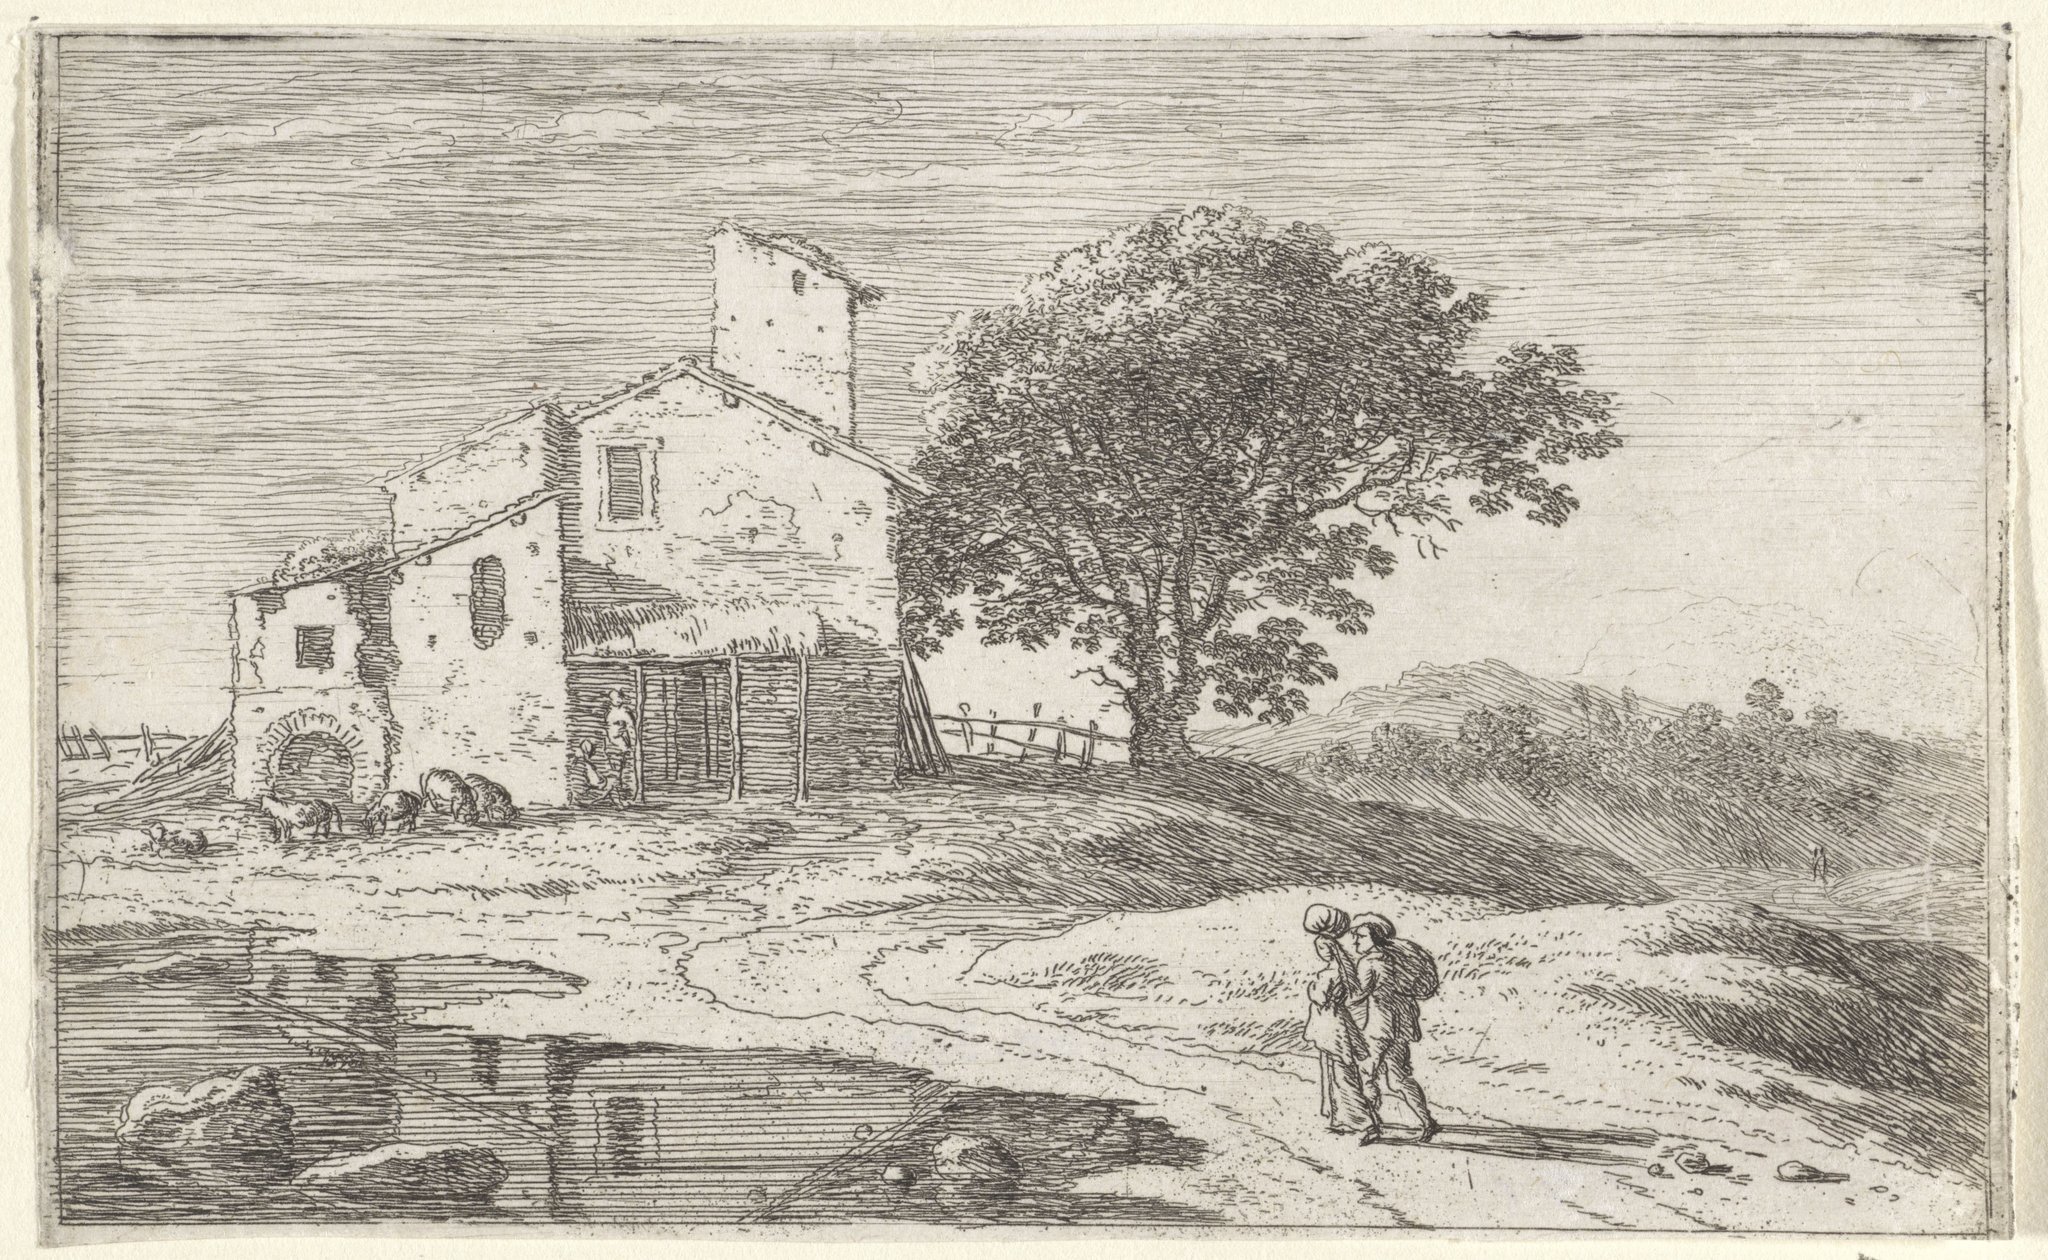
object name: print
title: Titelblad en twaalf gezichten op Rome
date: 1629-1655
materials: paper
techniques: etching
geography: rome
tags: landscapes, animals, rural housing, e.g. country-house, villa, cottage, farm or solitary house in landscape, rome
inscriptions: collector's mark: Lugt 240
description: Naast het huis of boerderij staat een grote boom en voor het huis scharrelen enkele dieren. Op het pad dat naar het huis leidt bevinden zich twee wandelaars.